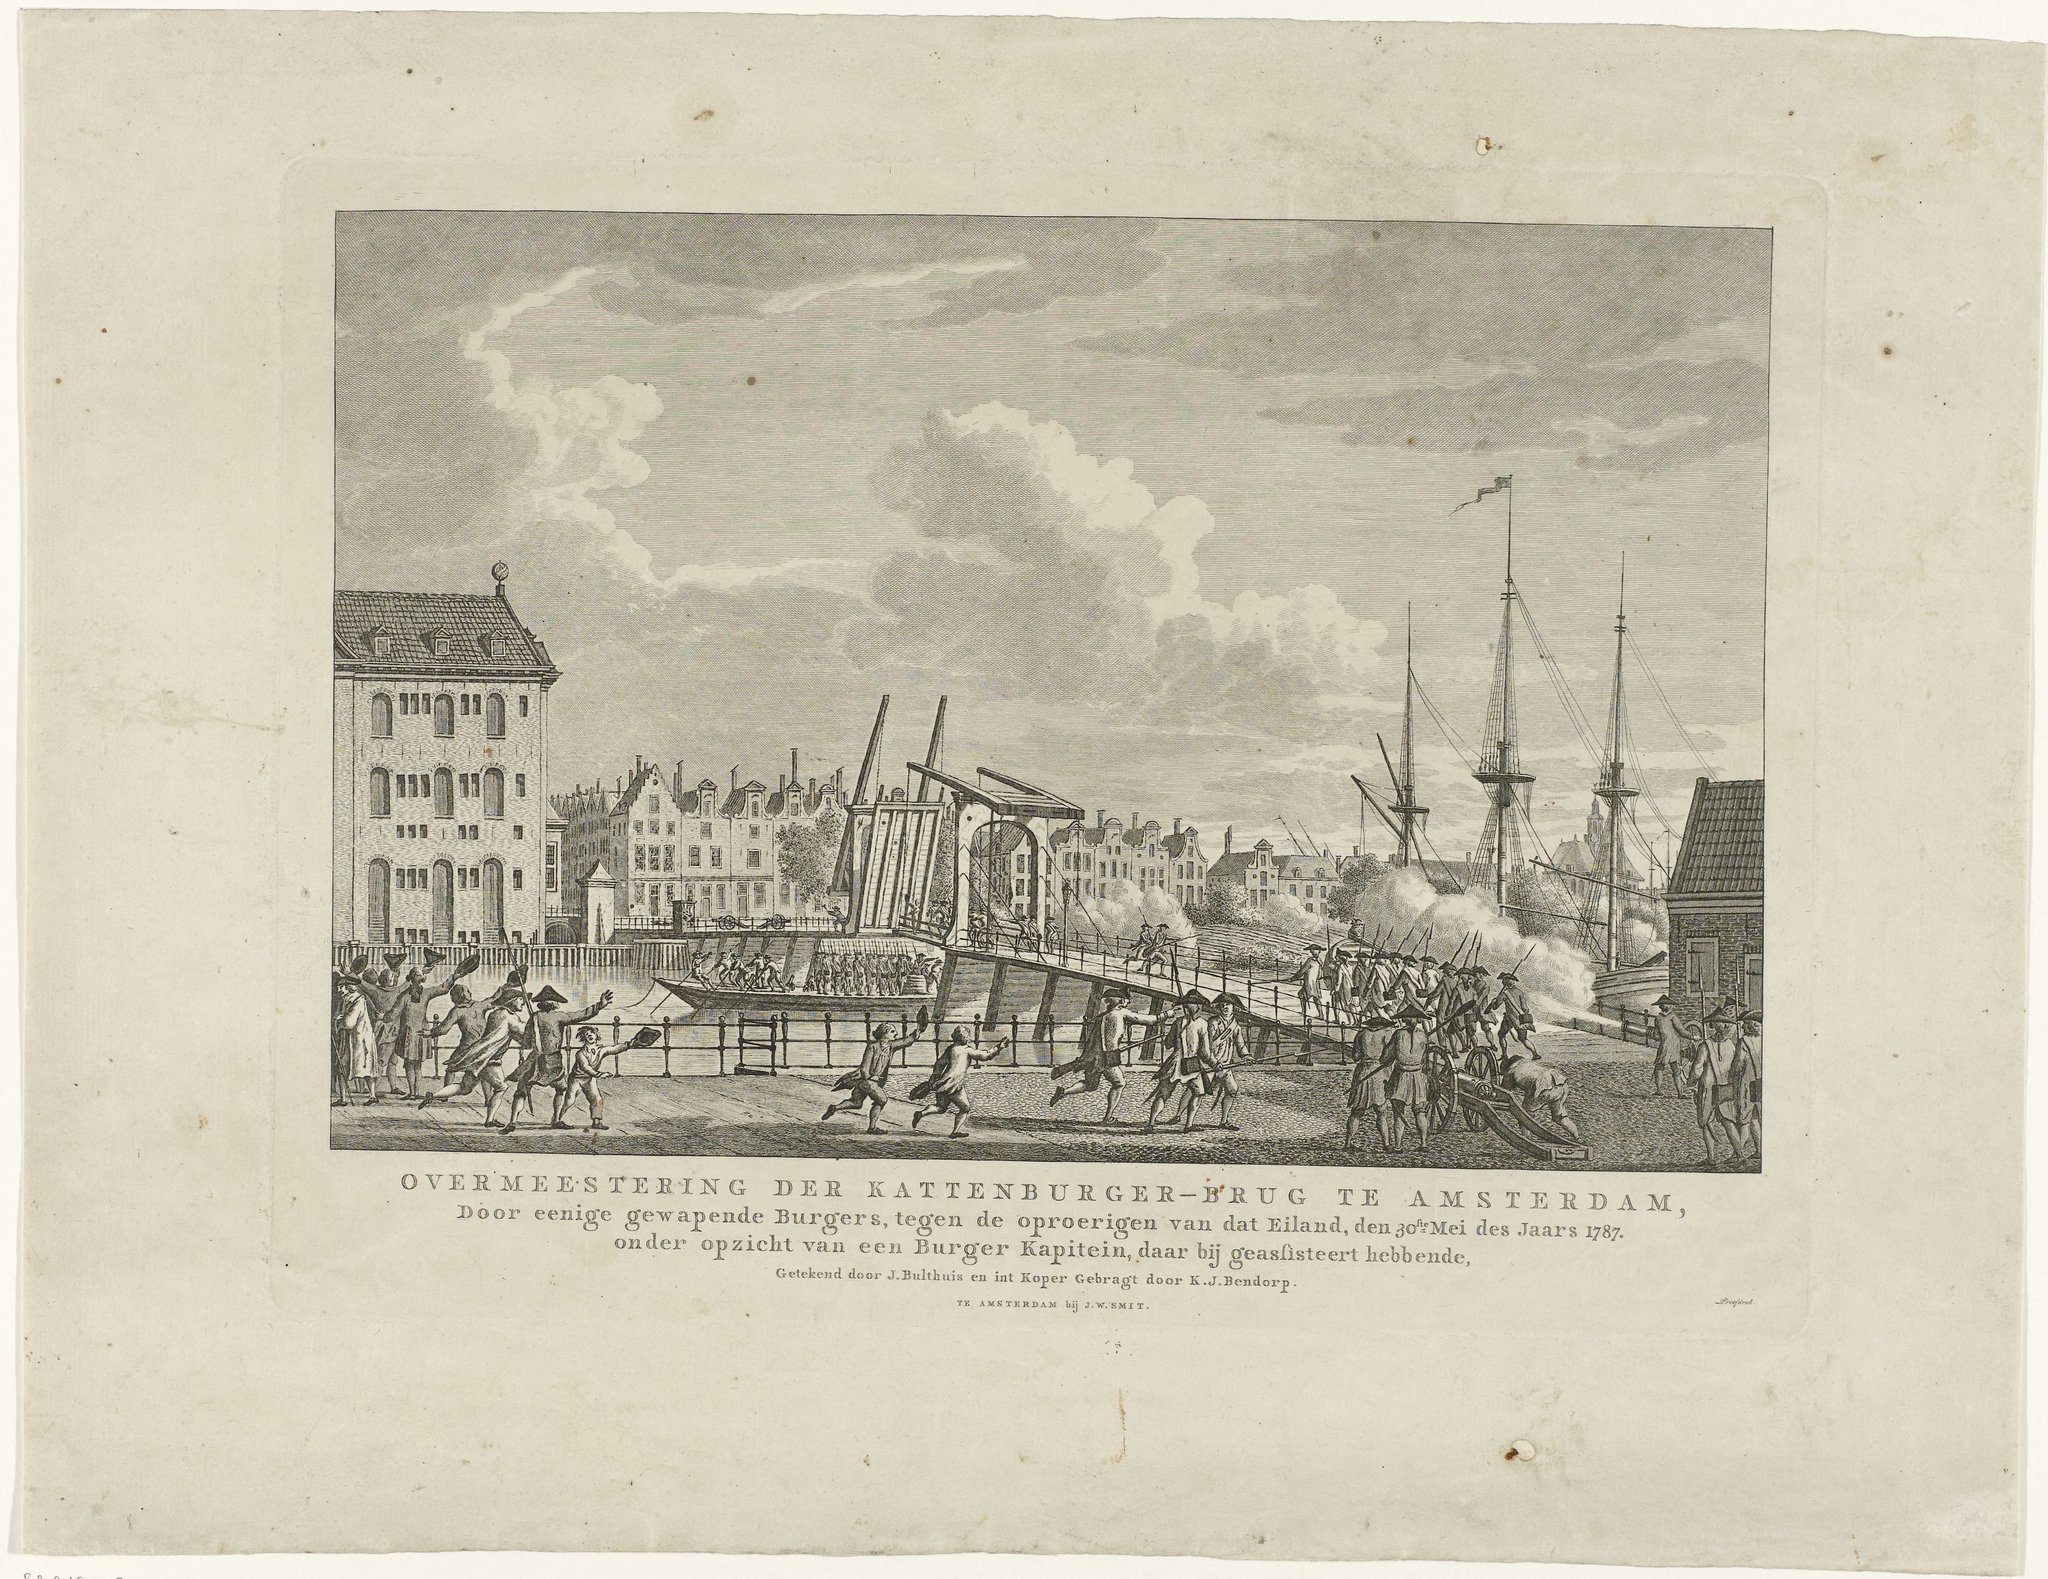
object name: print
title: Verovering van de Kattenburgerbrug, 1787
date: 1787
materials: paper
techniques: engraving, etching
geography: amsterdam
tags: battle (+ citizen soldiery, civil guard, citizen militia)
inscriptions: collector's mark: Lugt 2228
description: De verovering van de Kattenburgerbrug naar het eiland Kattenburg op de opstandige Oranjegezinden door de gewapende Amsterdamse burgers, 30 mei 1787. Links een deel van 's Lands Zeemagazijn.